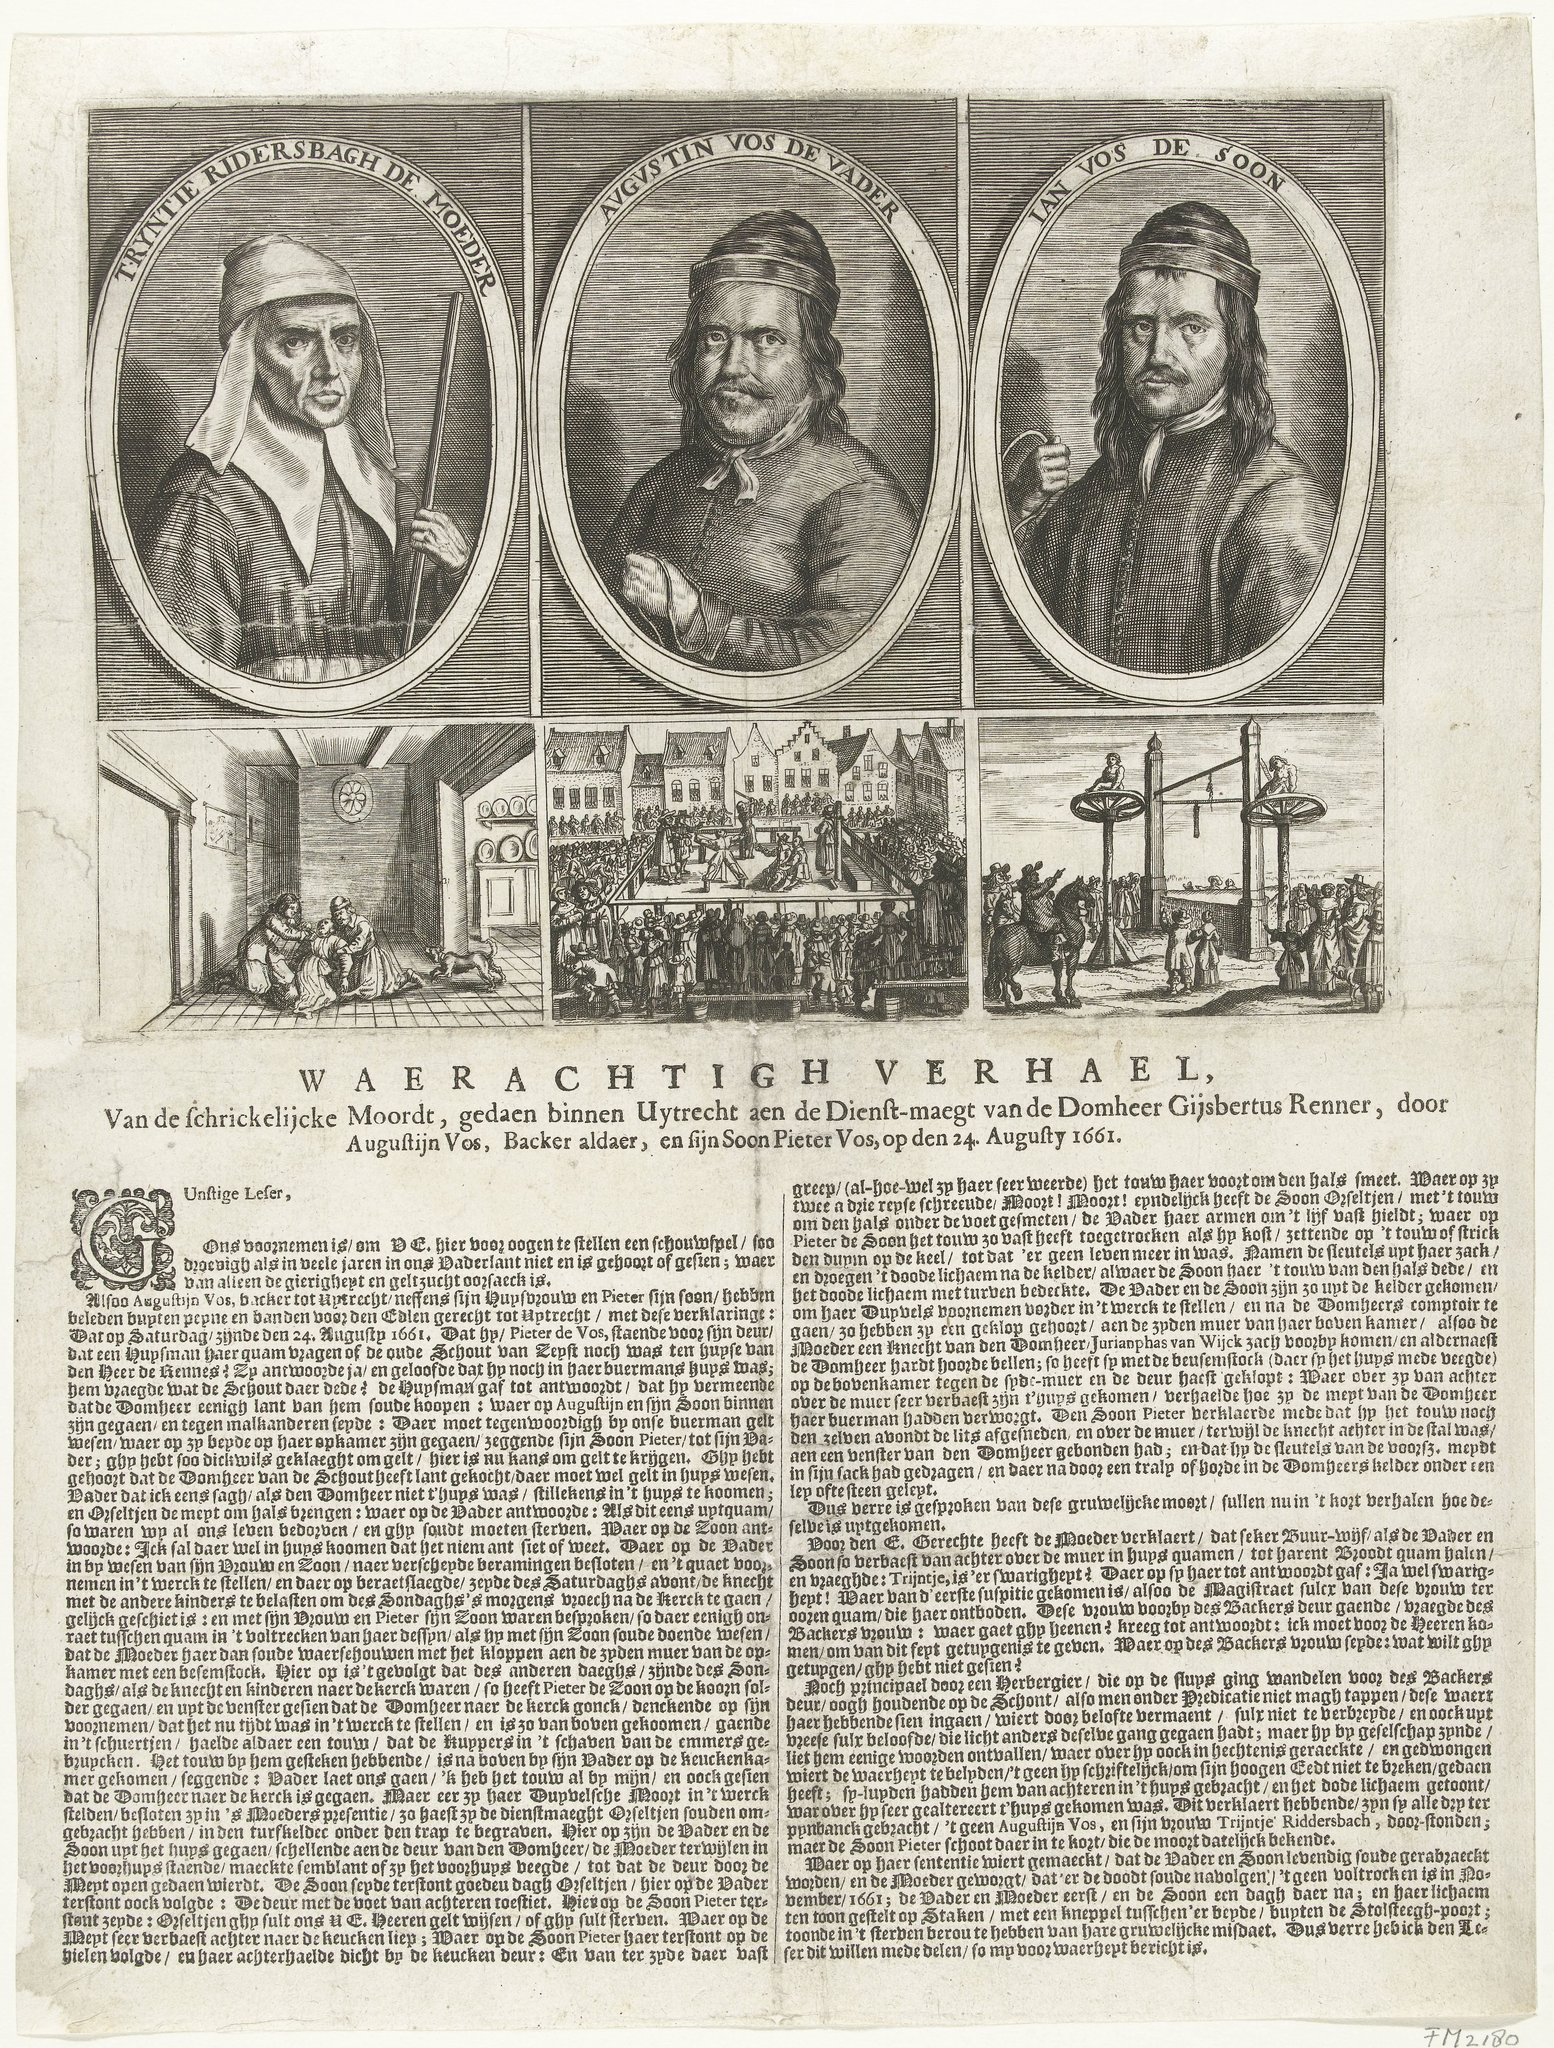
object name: print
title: Moord op de dienstmaagd van de domheer Gijsbertus Renner, te Utrecht 1661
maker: crispijn van de passe (ii)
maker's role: draughtsman, print maker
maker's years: 1594-1670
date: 1661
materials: paper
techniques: engraving, etching, letterpress printing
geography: amsterdam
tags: violent death by breaking on the wheel, murder, on the scaffold or place of execution, body of the executed displayed in public, utrecht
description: Moord op de dienstmaagd van de domheer Gijsbertus Renner (of Reuver), te Utrecht, 24 augustus 1661. Blad met bovenaan de portretten van de moordenaars, de bakker Augustijn Vos en zijn zoon Pieter Vos met de echtgenote en moeder Trijntje Ridersbagh. Daaronder drie scènes van de moord, de terechtstelling van de moordenaars en het tentoonstellen van hun geradbraakte lichamen in november 1661. Op het blad onder de plaat een tekst in twee kolommen.